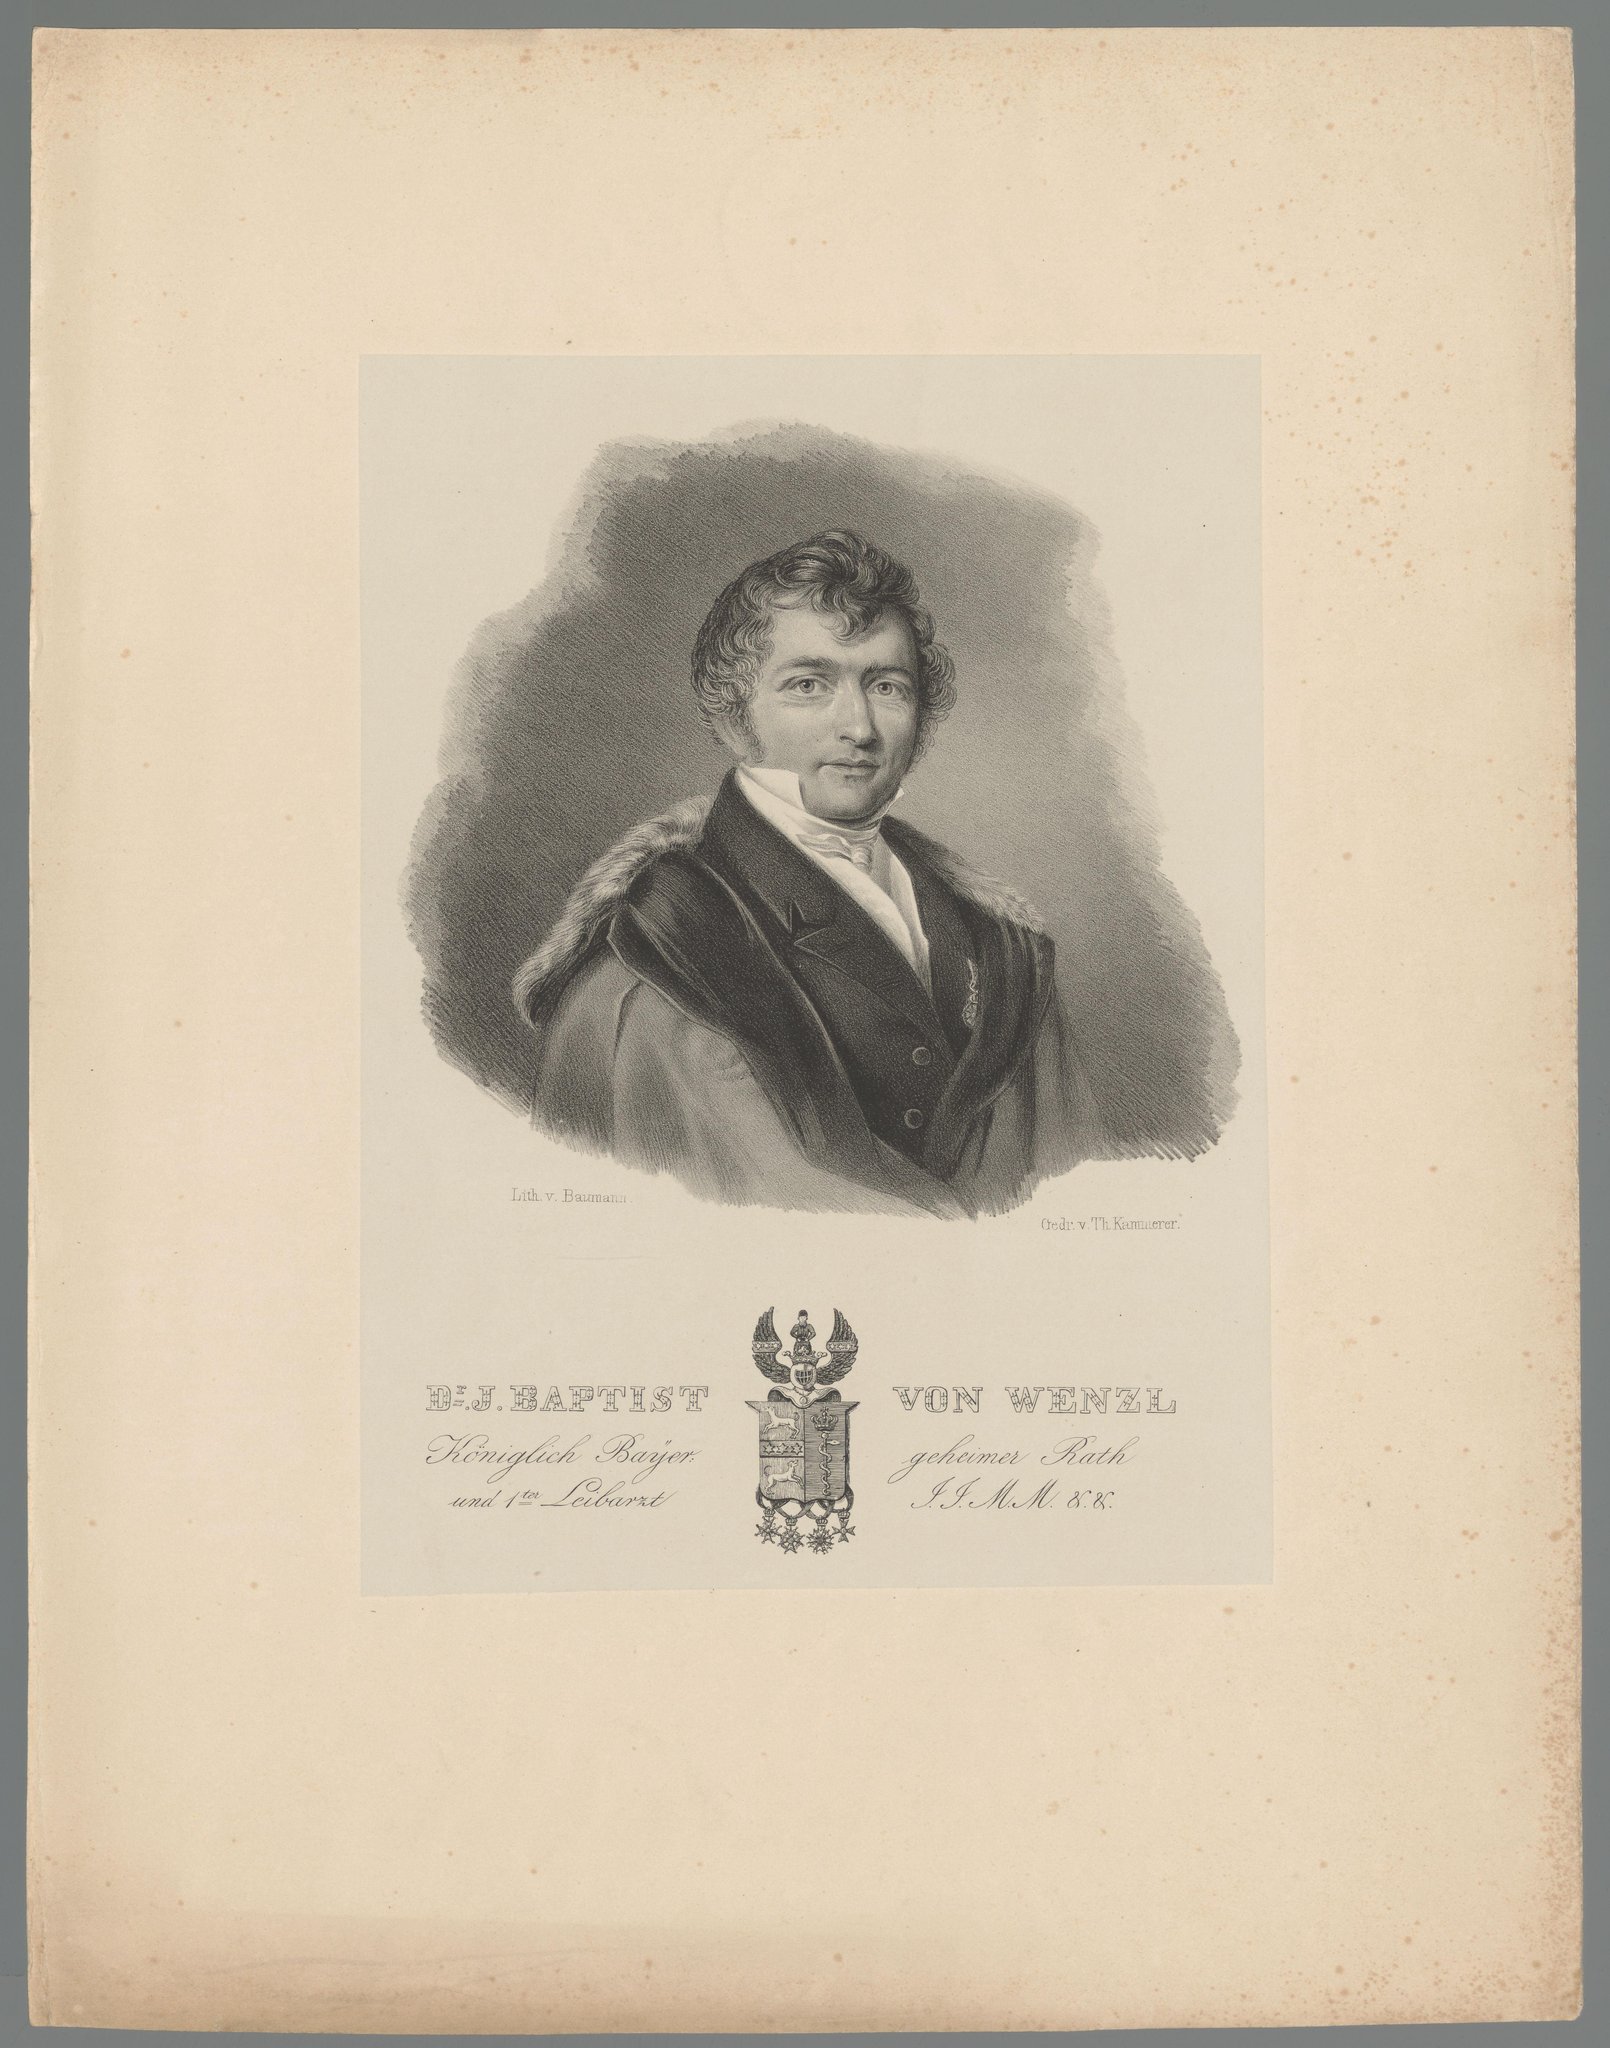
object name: print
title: Portret van J. Baptist von Wenzel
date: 1825-1899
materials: paper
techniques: lithograph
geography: munich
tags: adult man, historical persons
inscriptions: collector's mark: Lugt 2228